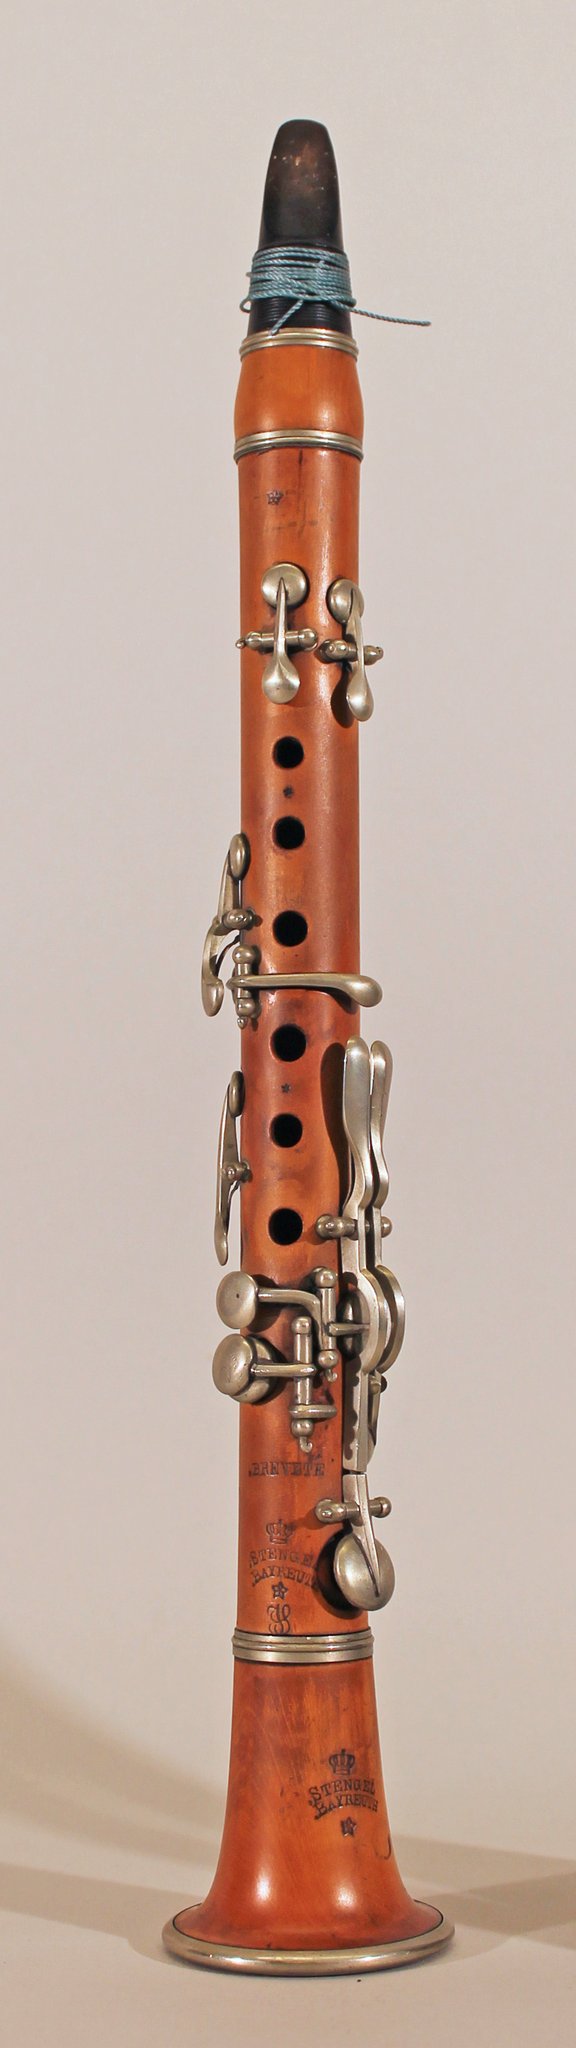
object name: piccolo clarinet in a flat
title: Piccolo Clarinet in A-flat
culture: german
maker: johann samuel stengel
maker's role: maker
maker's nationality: german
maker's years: 1805-1902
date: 1850-1860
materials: wood, brass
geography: germany